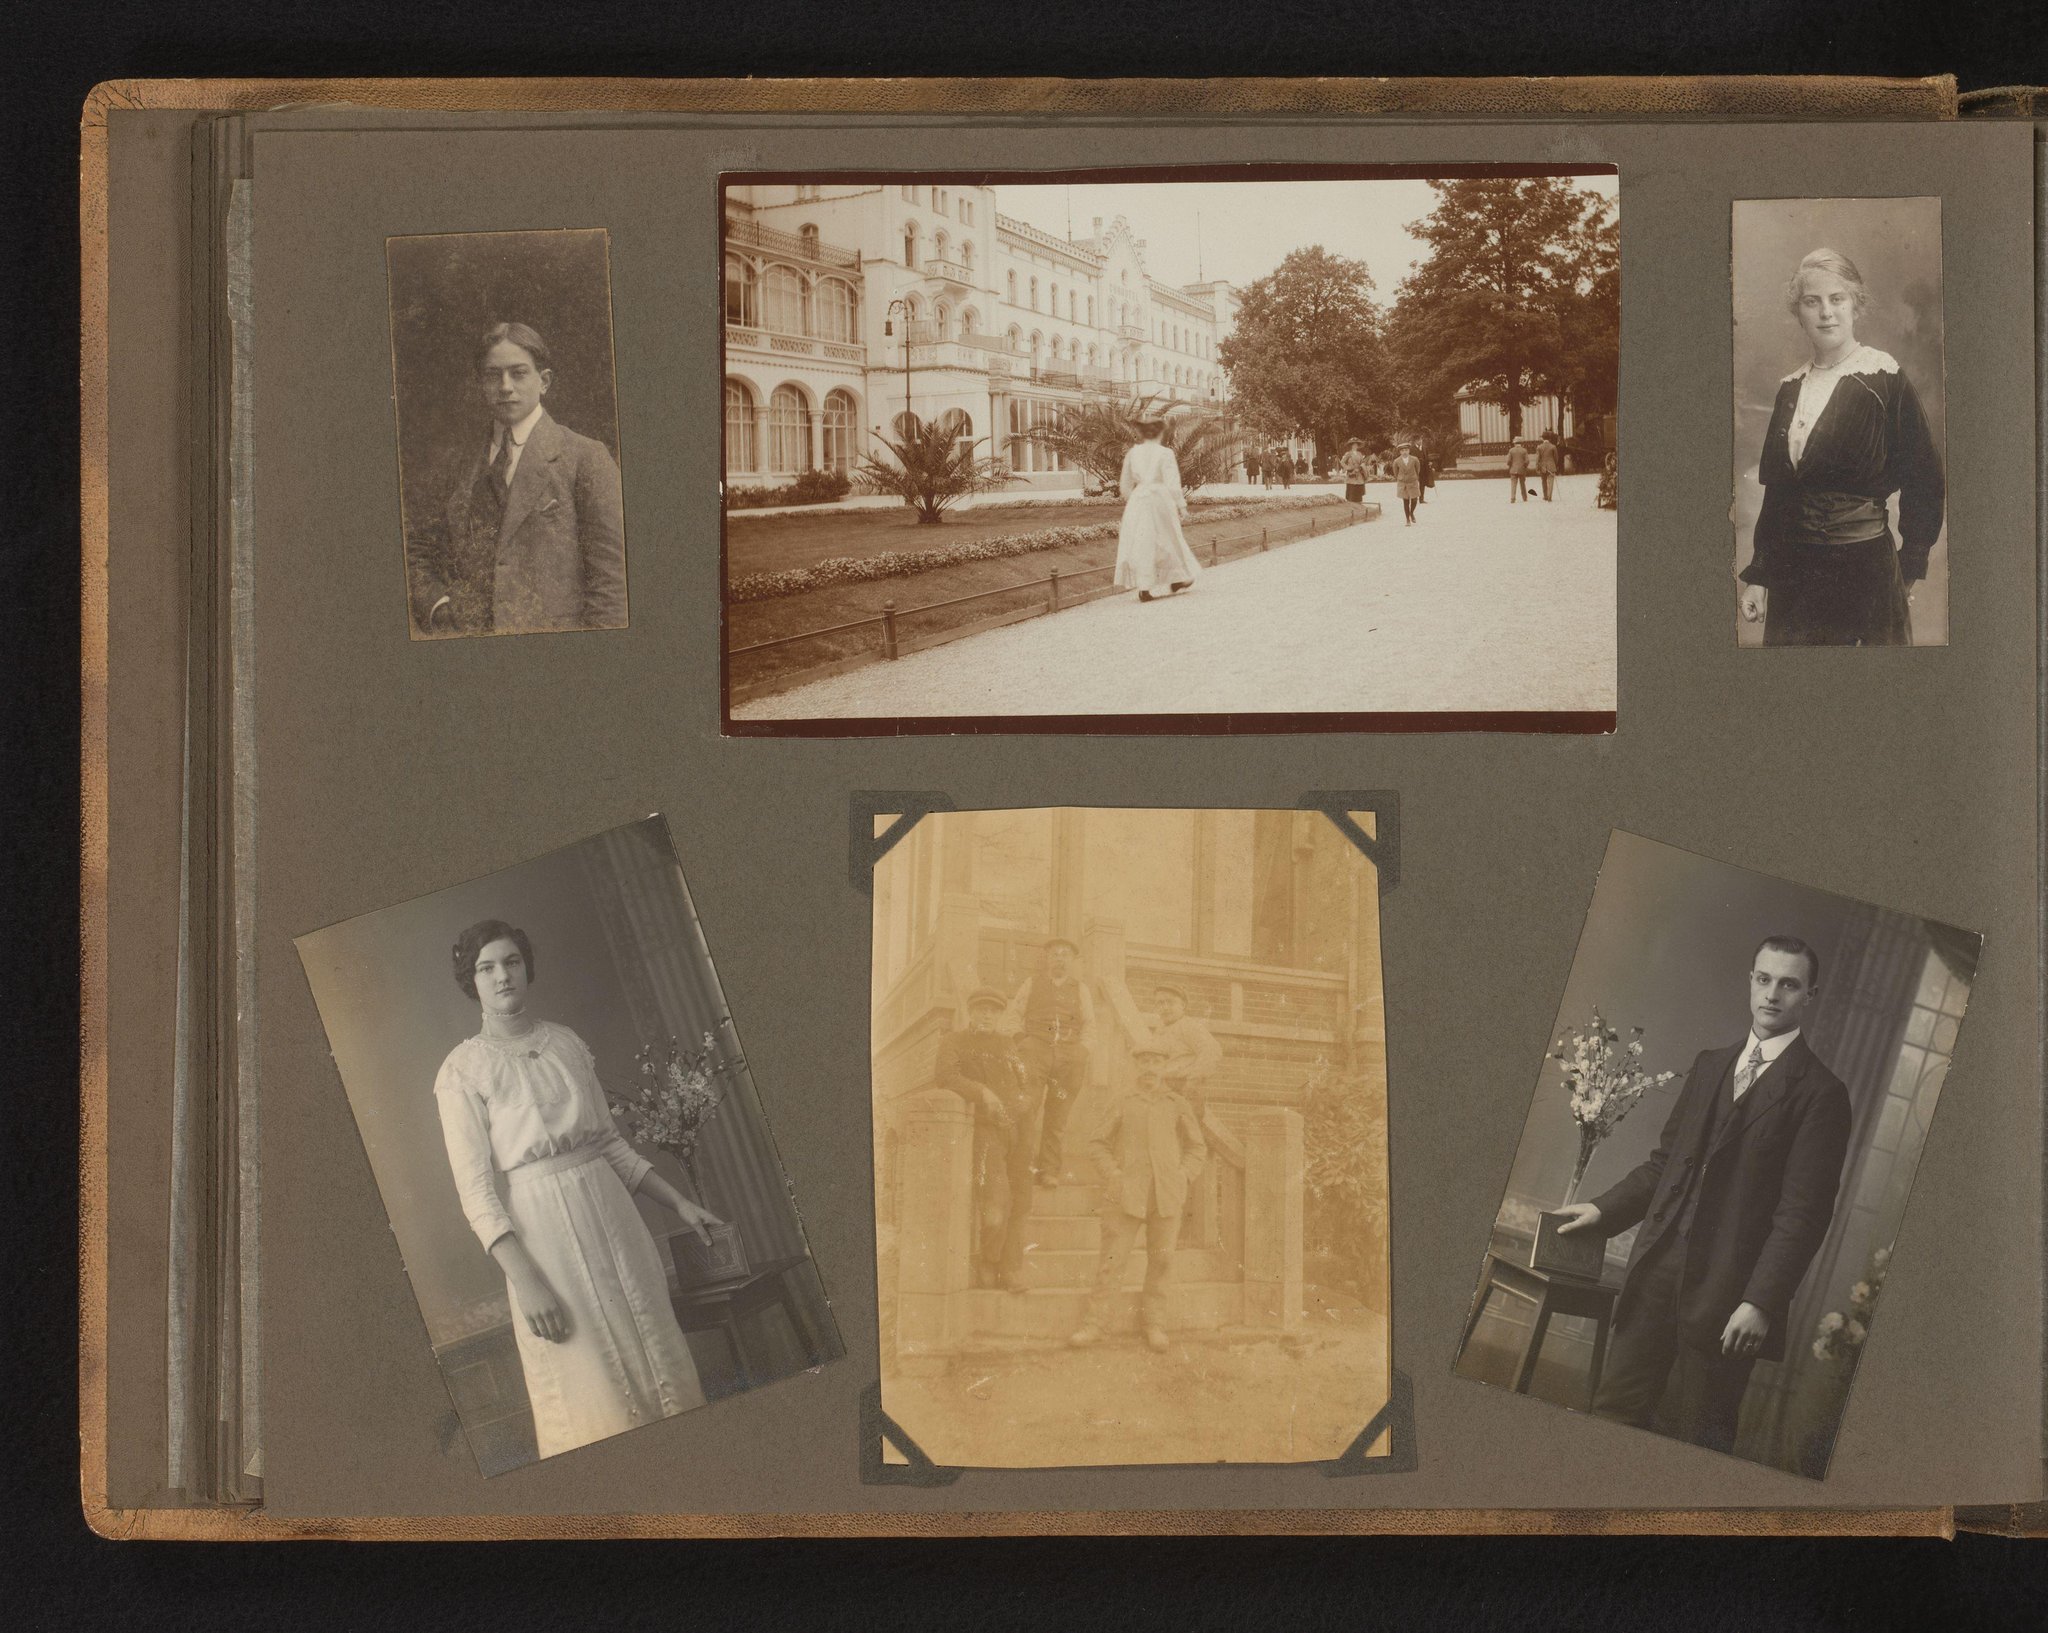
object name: photograph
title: Portretten en een gezicht op een gebouw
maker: Anonymous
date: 1900-1950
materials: photographic support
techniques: albumen print, gelatin silver print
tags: adolescent, young woman, maiden, adult man, child, historical persons, civic architecture; edifices; dwellings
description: Portretten van jonge vrouwen en jonge mannen en een groepsportret van mannen. Deze pagina maakt deel uit van een album.